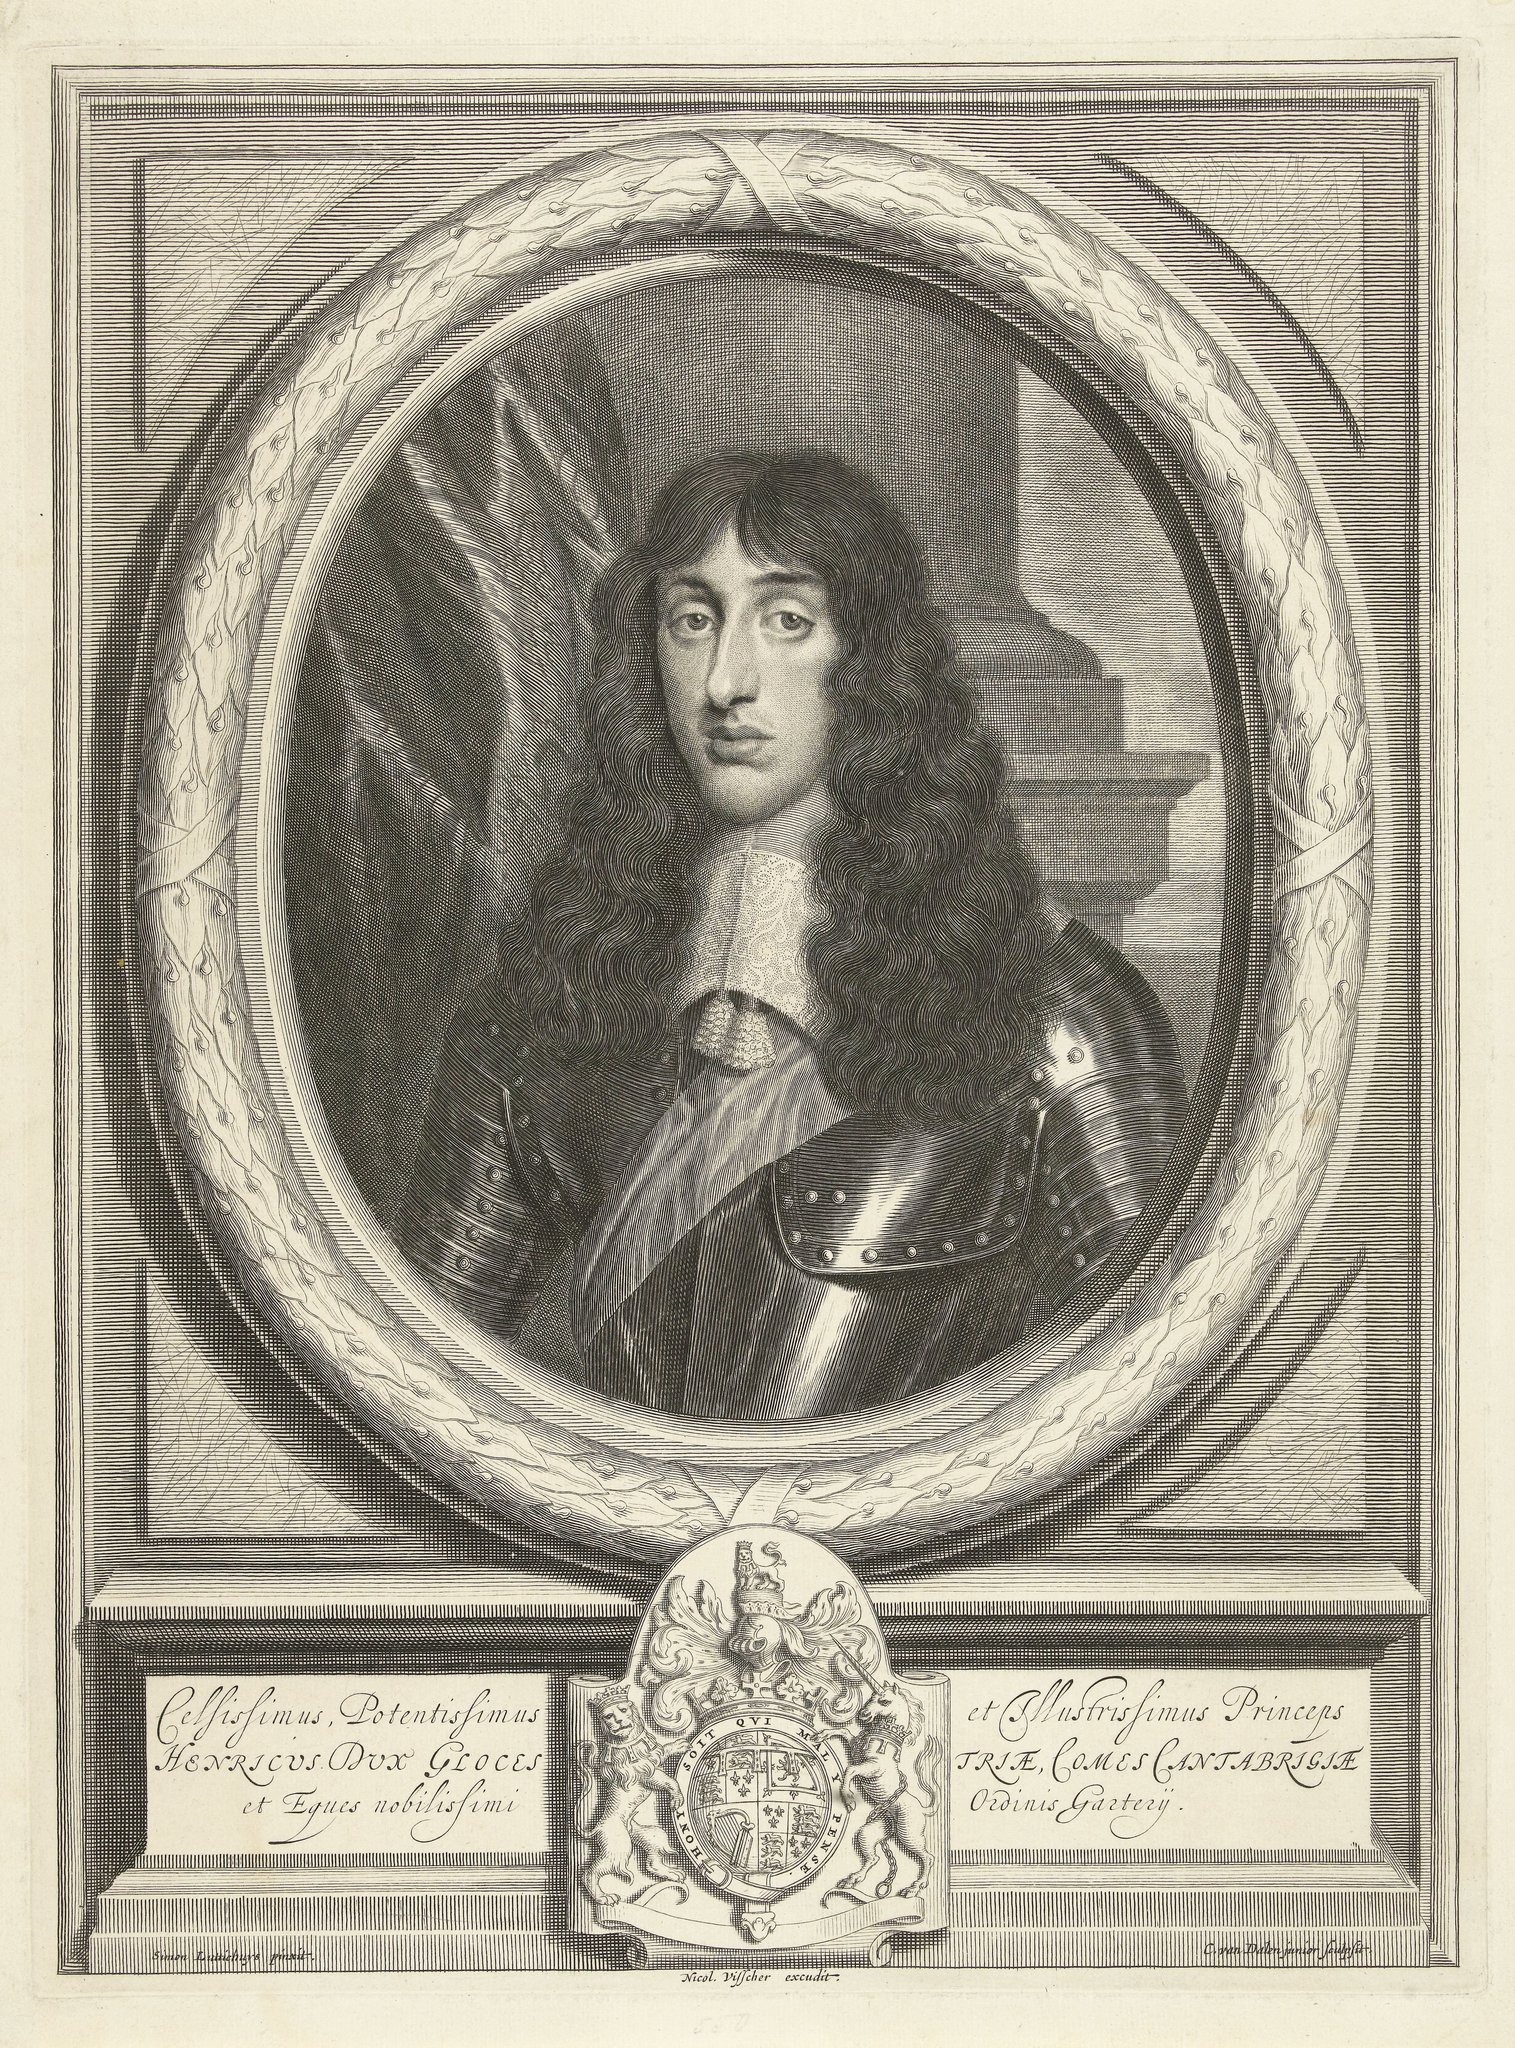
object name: print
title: Portret van Henry Stuart in ovale omlijsting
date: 1648-1664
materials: paper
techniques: engraving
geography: amsterdam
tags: london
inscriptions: collector's mark: Lugt 2228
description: Portret van Henry Stuart, hertog van Gloucester, borststuk gekleed in harnas in ovale omlijsting met lauwerkrans. Basis met wapenschild en Latijns opschrift.